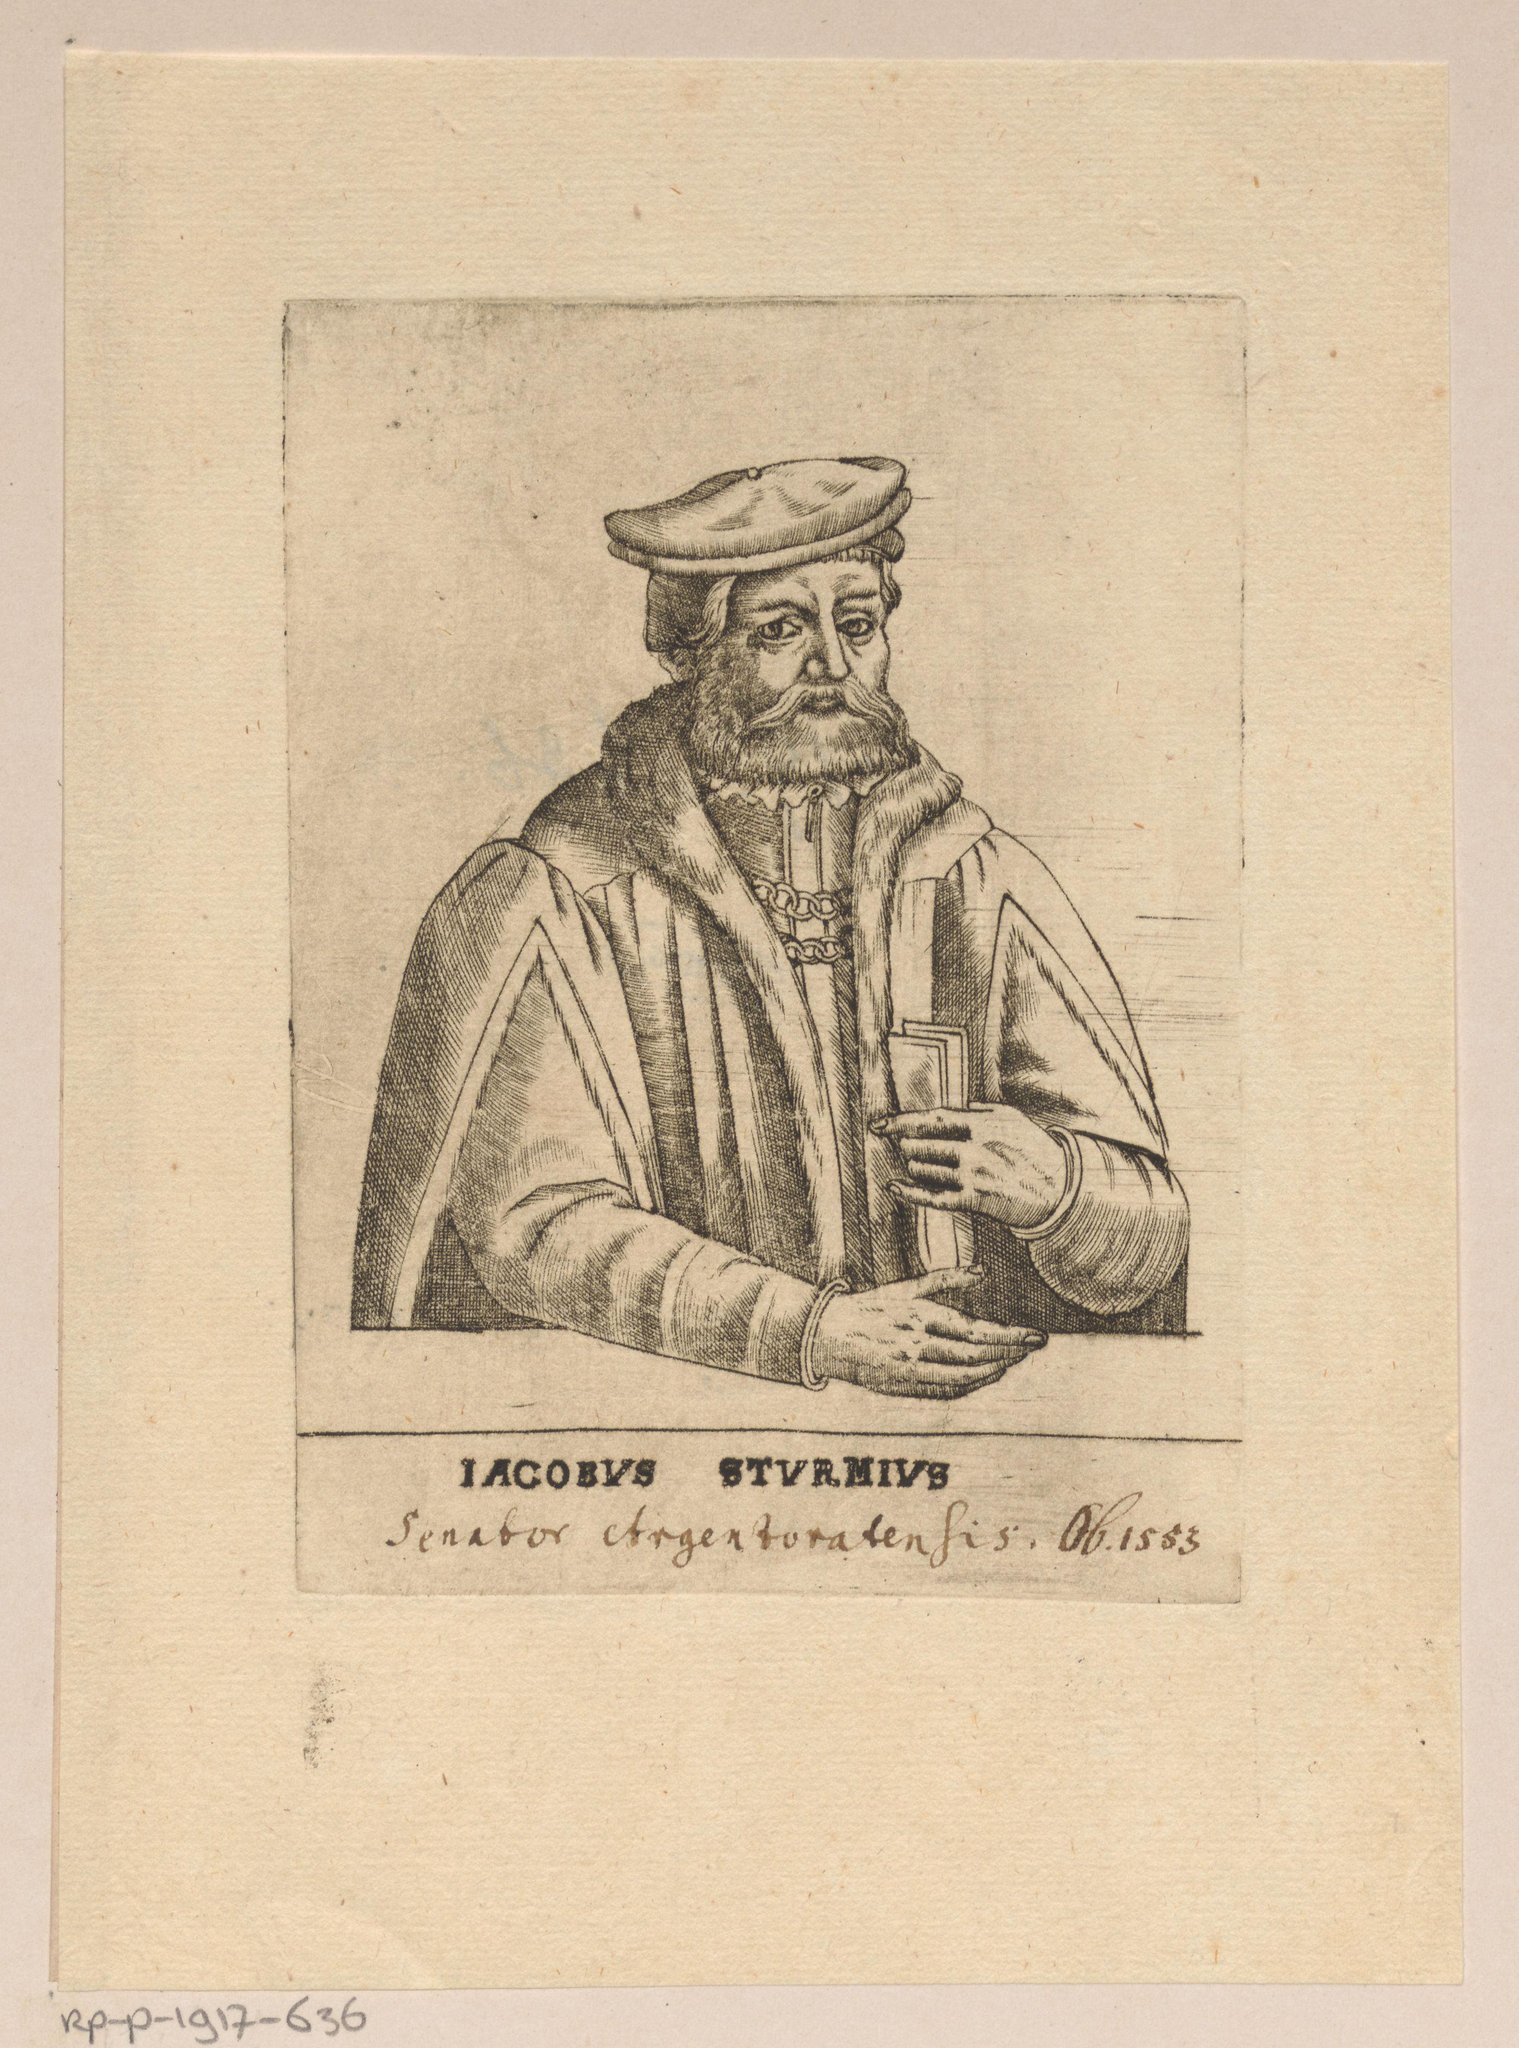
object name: print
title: Portret van Jakob Sturm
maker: Anonymous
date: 1600-1690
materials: paper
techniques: engraving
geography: germany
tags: official; civil servant; functionary (in general), historical persons, lawyer, attorney at law